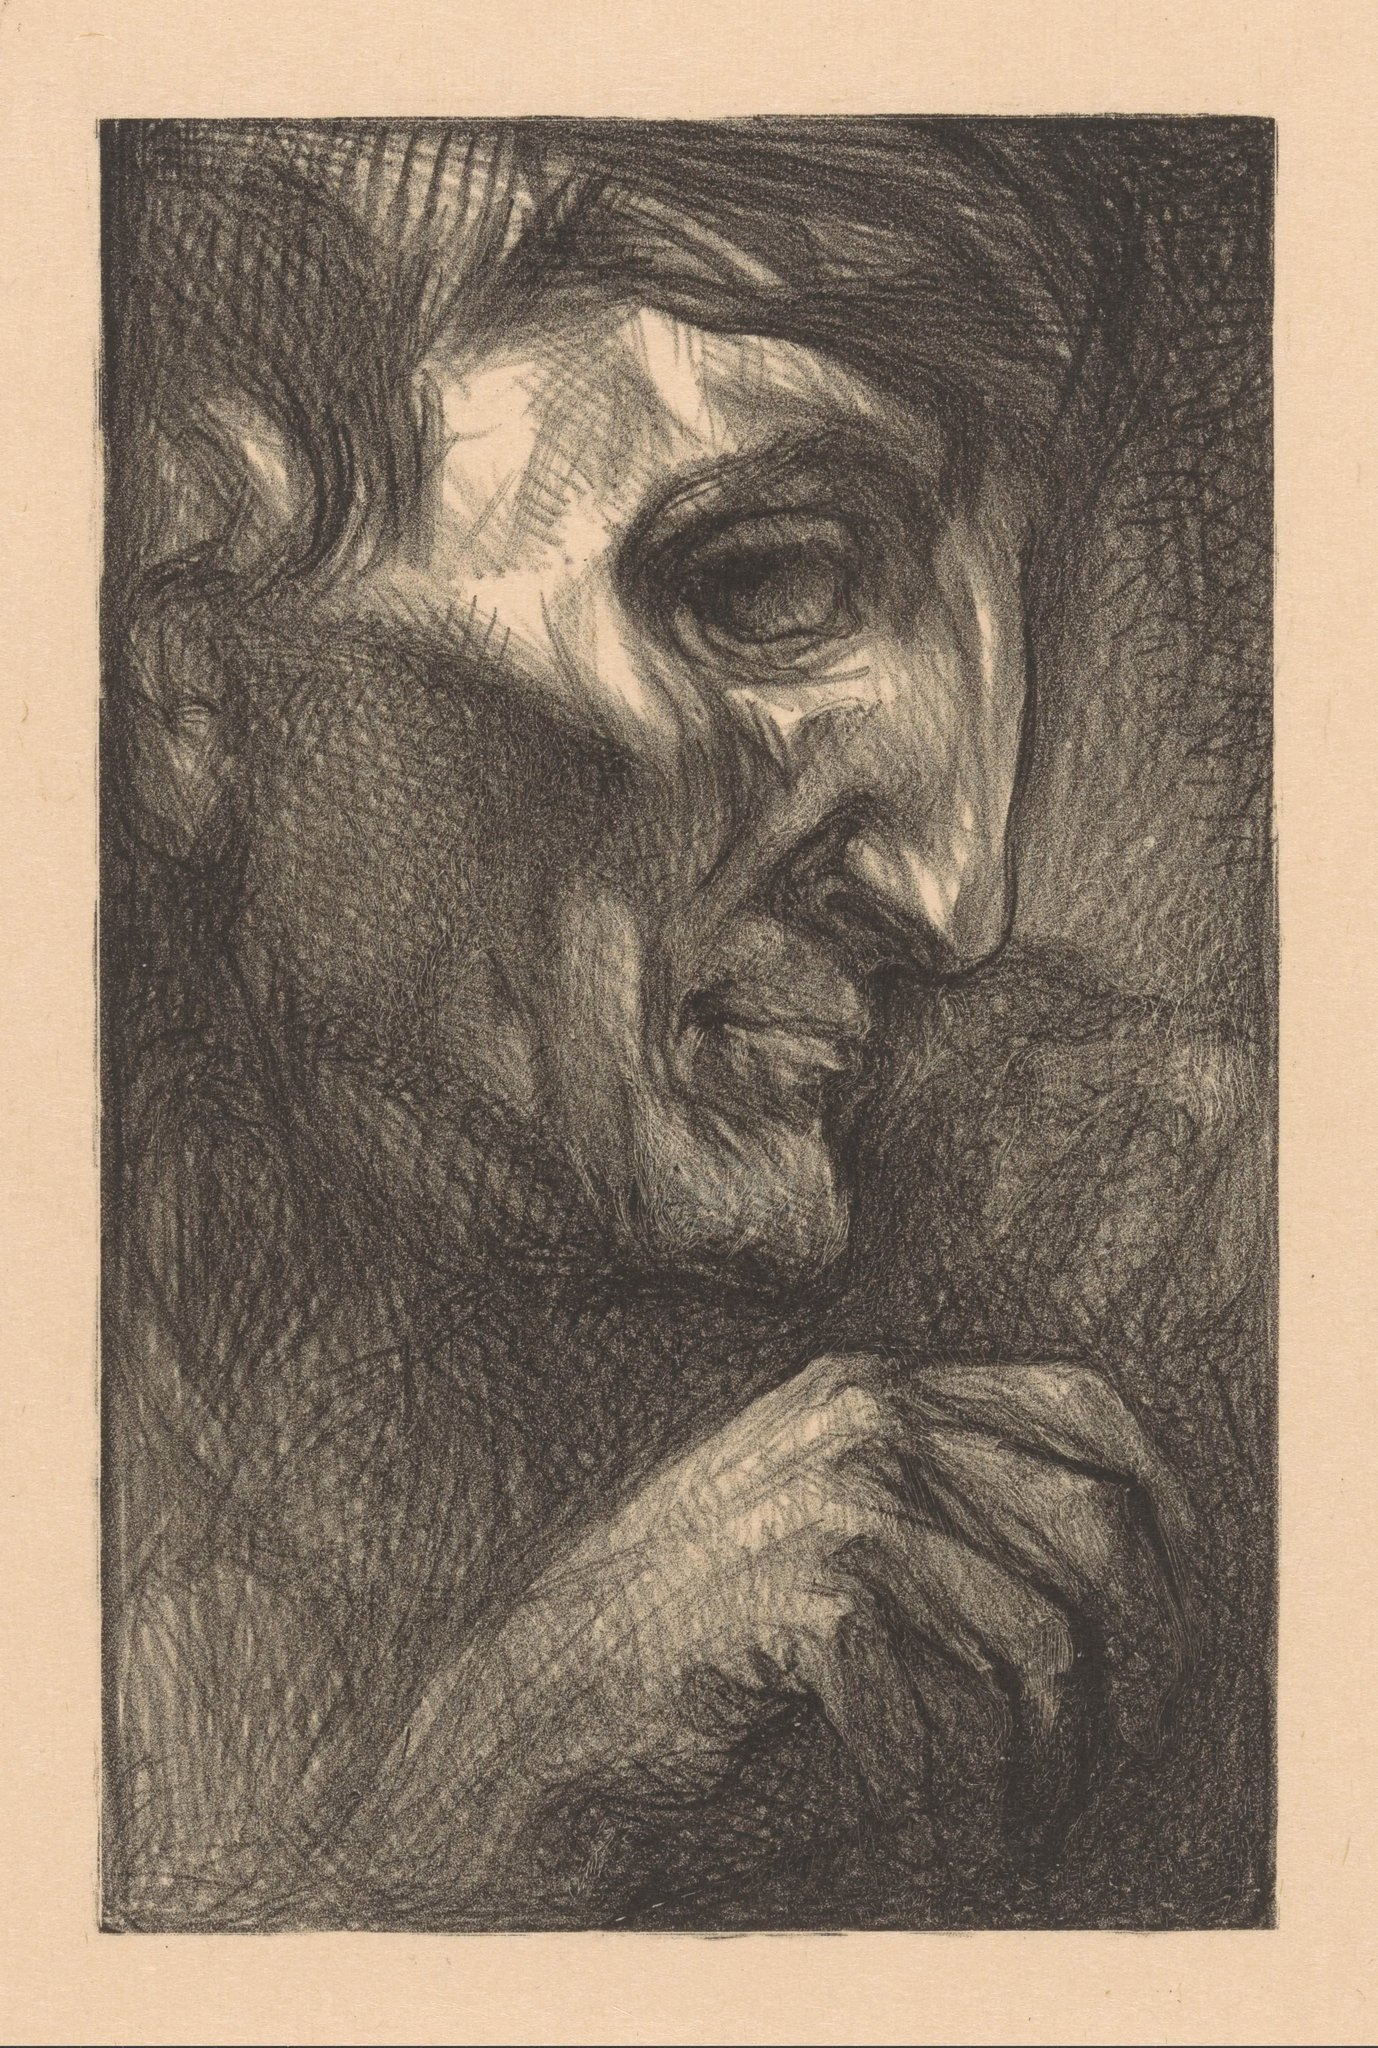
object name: print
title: Hoofd en hand van een man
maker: johannes josephus aarts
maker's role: draughtsman, print maker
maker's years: 1871-1934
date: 1881-1934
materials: paper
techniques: lithograph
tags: head (human) (+ sideview, profile), hand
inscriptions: collector's mark: Lugt 2228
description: Het hoofd en de hand van een man, in profiel gezien.